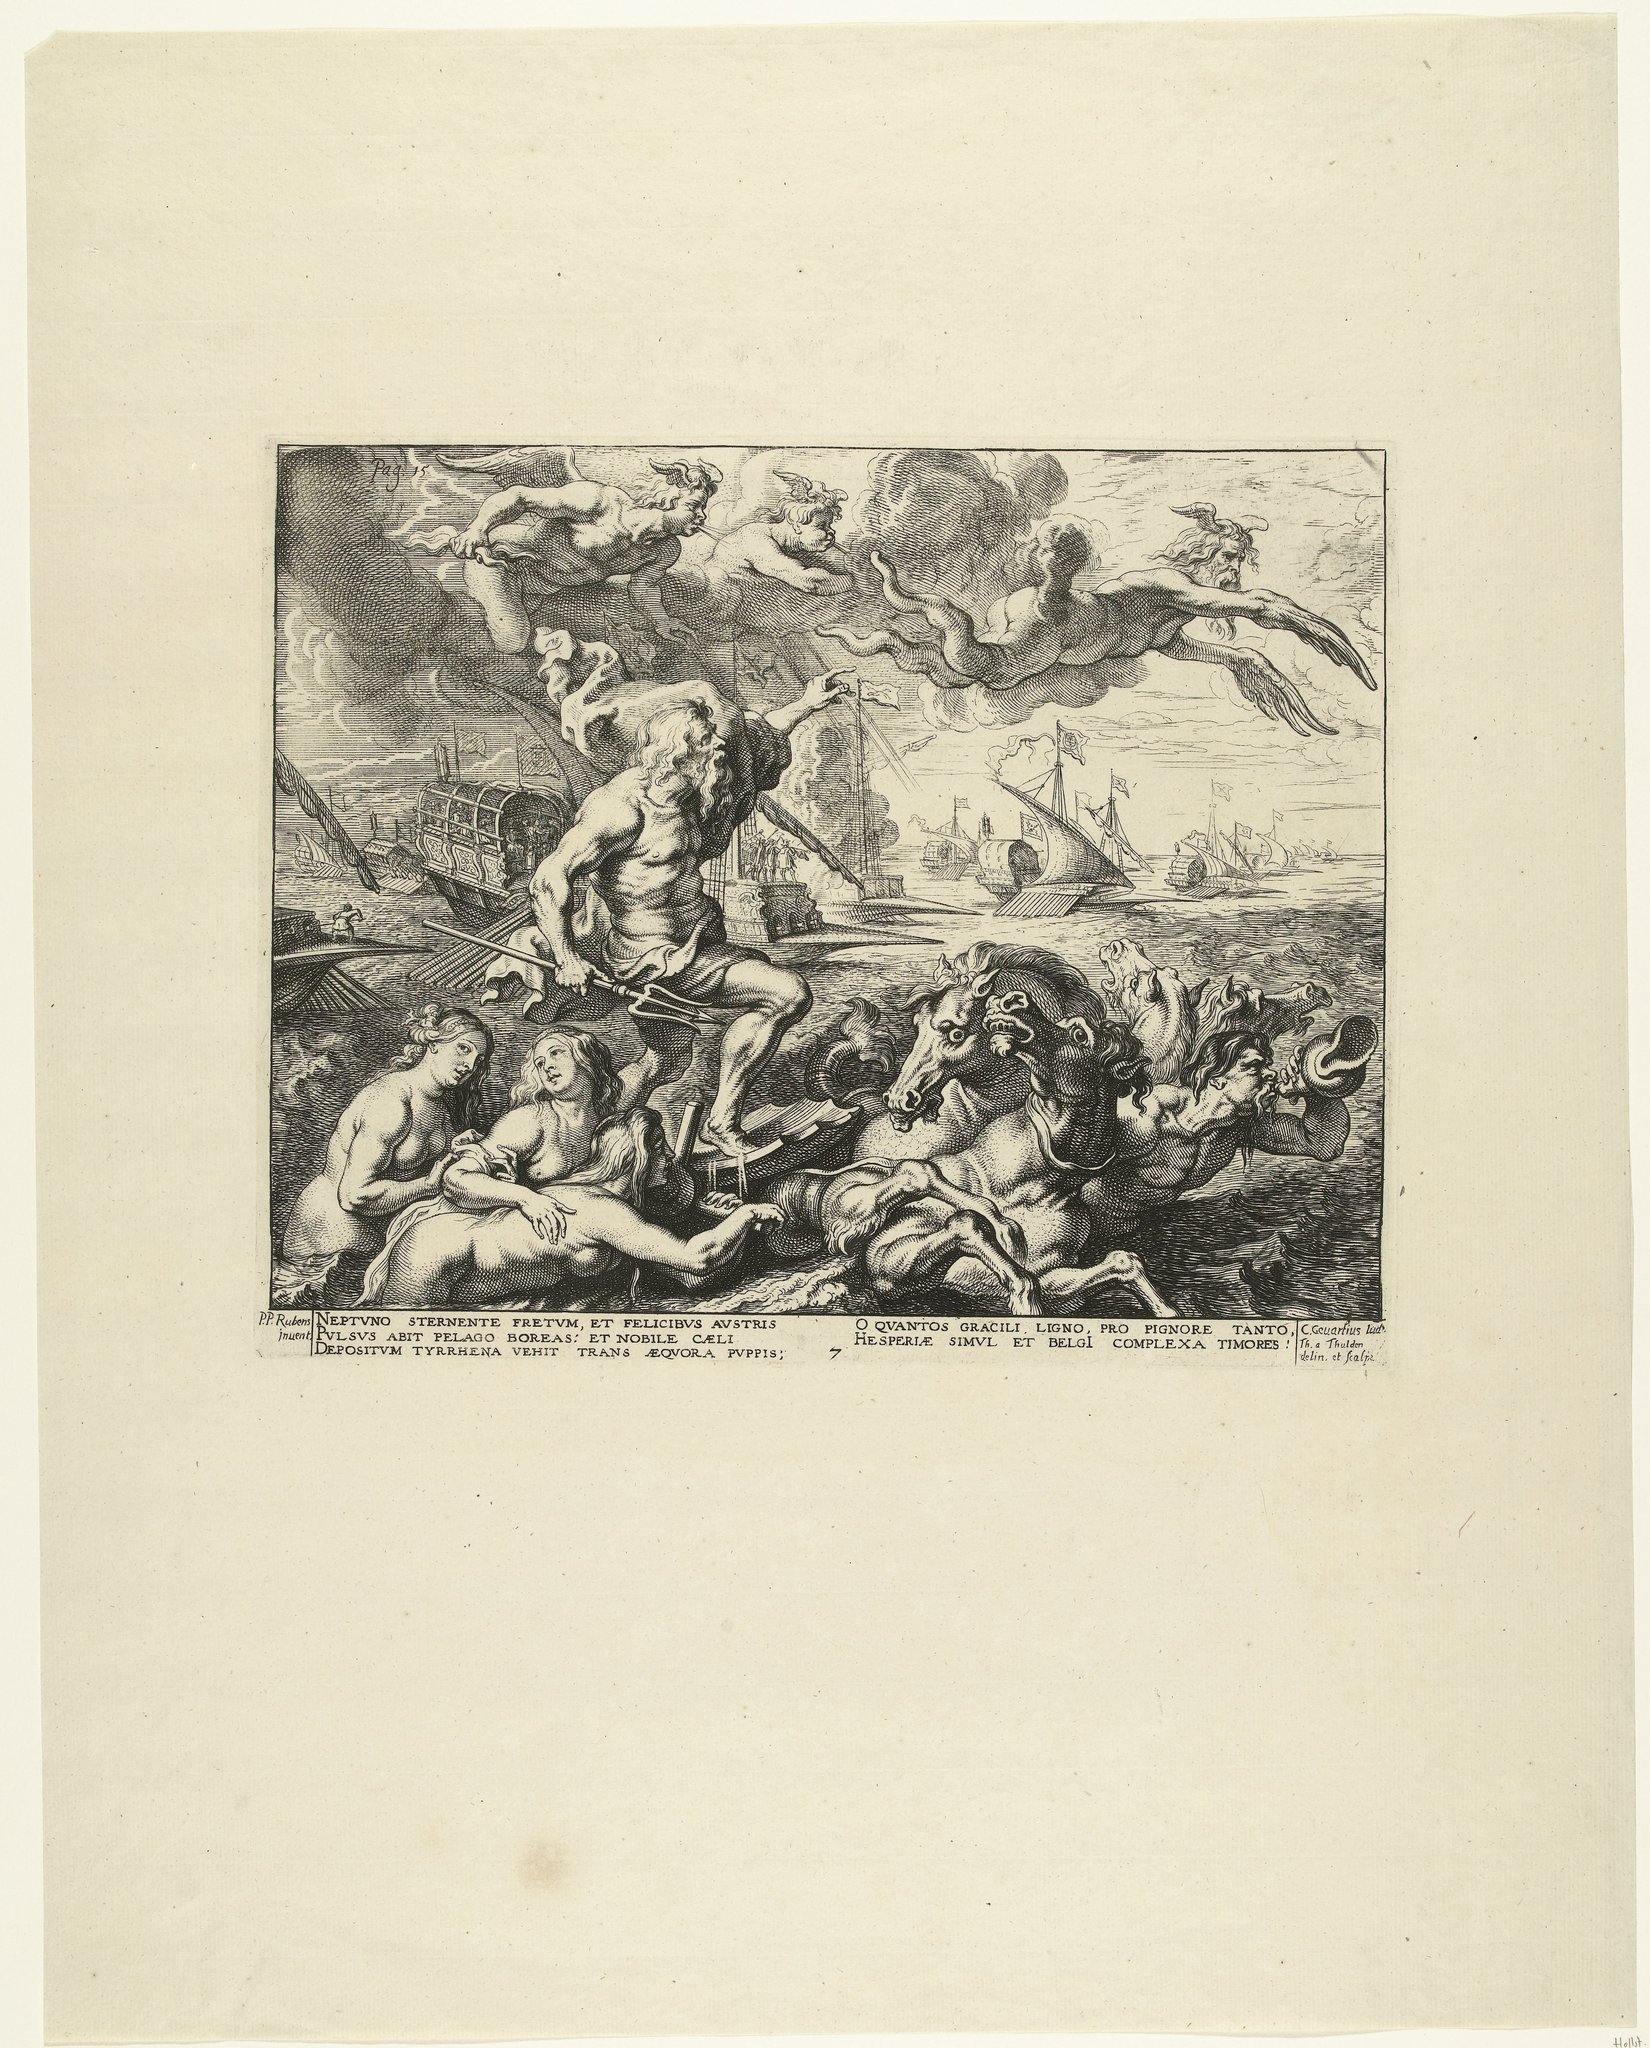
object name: print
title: De tocht van Barcelona naar Genua; intocht van Ferdinand te Antwerpen in 1635 (nr. 7)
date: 1639-1641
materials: paper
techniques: engraving, etching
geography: southern netherlands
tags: landvoogd der zuidelijke nederlanden ferdinand van oostenrijk, north wind, 'aquilo', 'boreas', 'septentrionarius' (one of eight directions), triumphal entry and public reception, pageant, 'entrée solennelle', 'joyeuse entrée', specific aspects, allegorical aspects of neptune; neptune as patron, antwerp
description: Ferdinands reis over zee van Barcelona naar Genua in Italië (11 april - 5 mei 1633). Op de voorgrond Neptunus in zijn strijdwagen met zeenimfen, de noorderwind Boreas wordt verjaagd. De linker voorstelling op het welkomsttoneel. Gemerkt linksboven: Pag. 15. Met onderschrift van 5 regels in het Latijn. Blad nr. 7 in een geheel van 43 platen die de uitgave van de beschrijving van de intocht van de Kardinaal Infant Ferdinand van Oostenrijk te Antwerpen op 17 april 1635 als de nieuwe landvoogd voor de Spaanse Nederlanden illustreren.